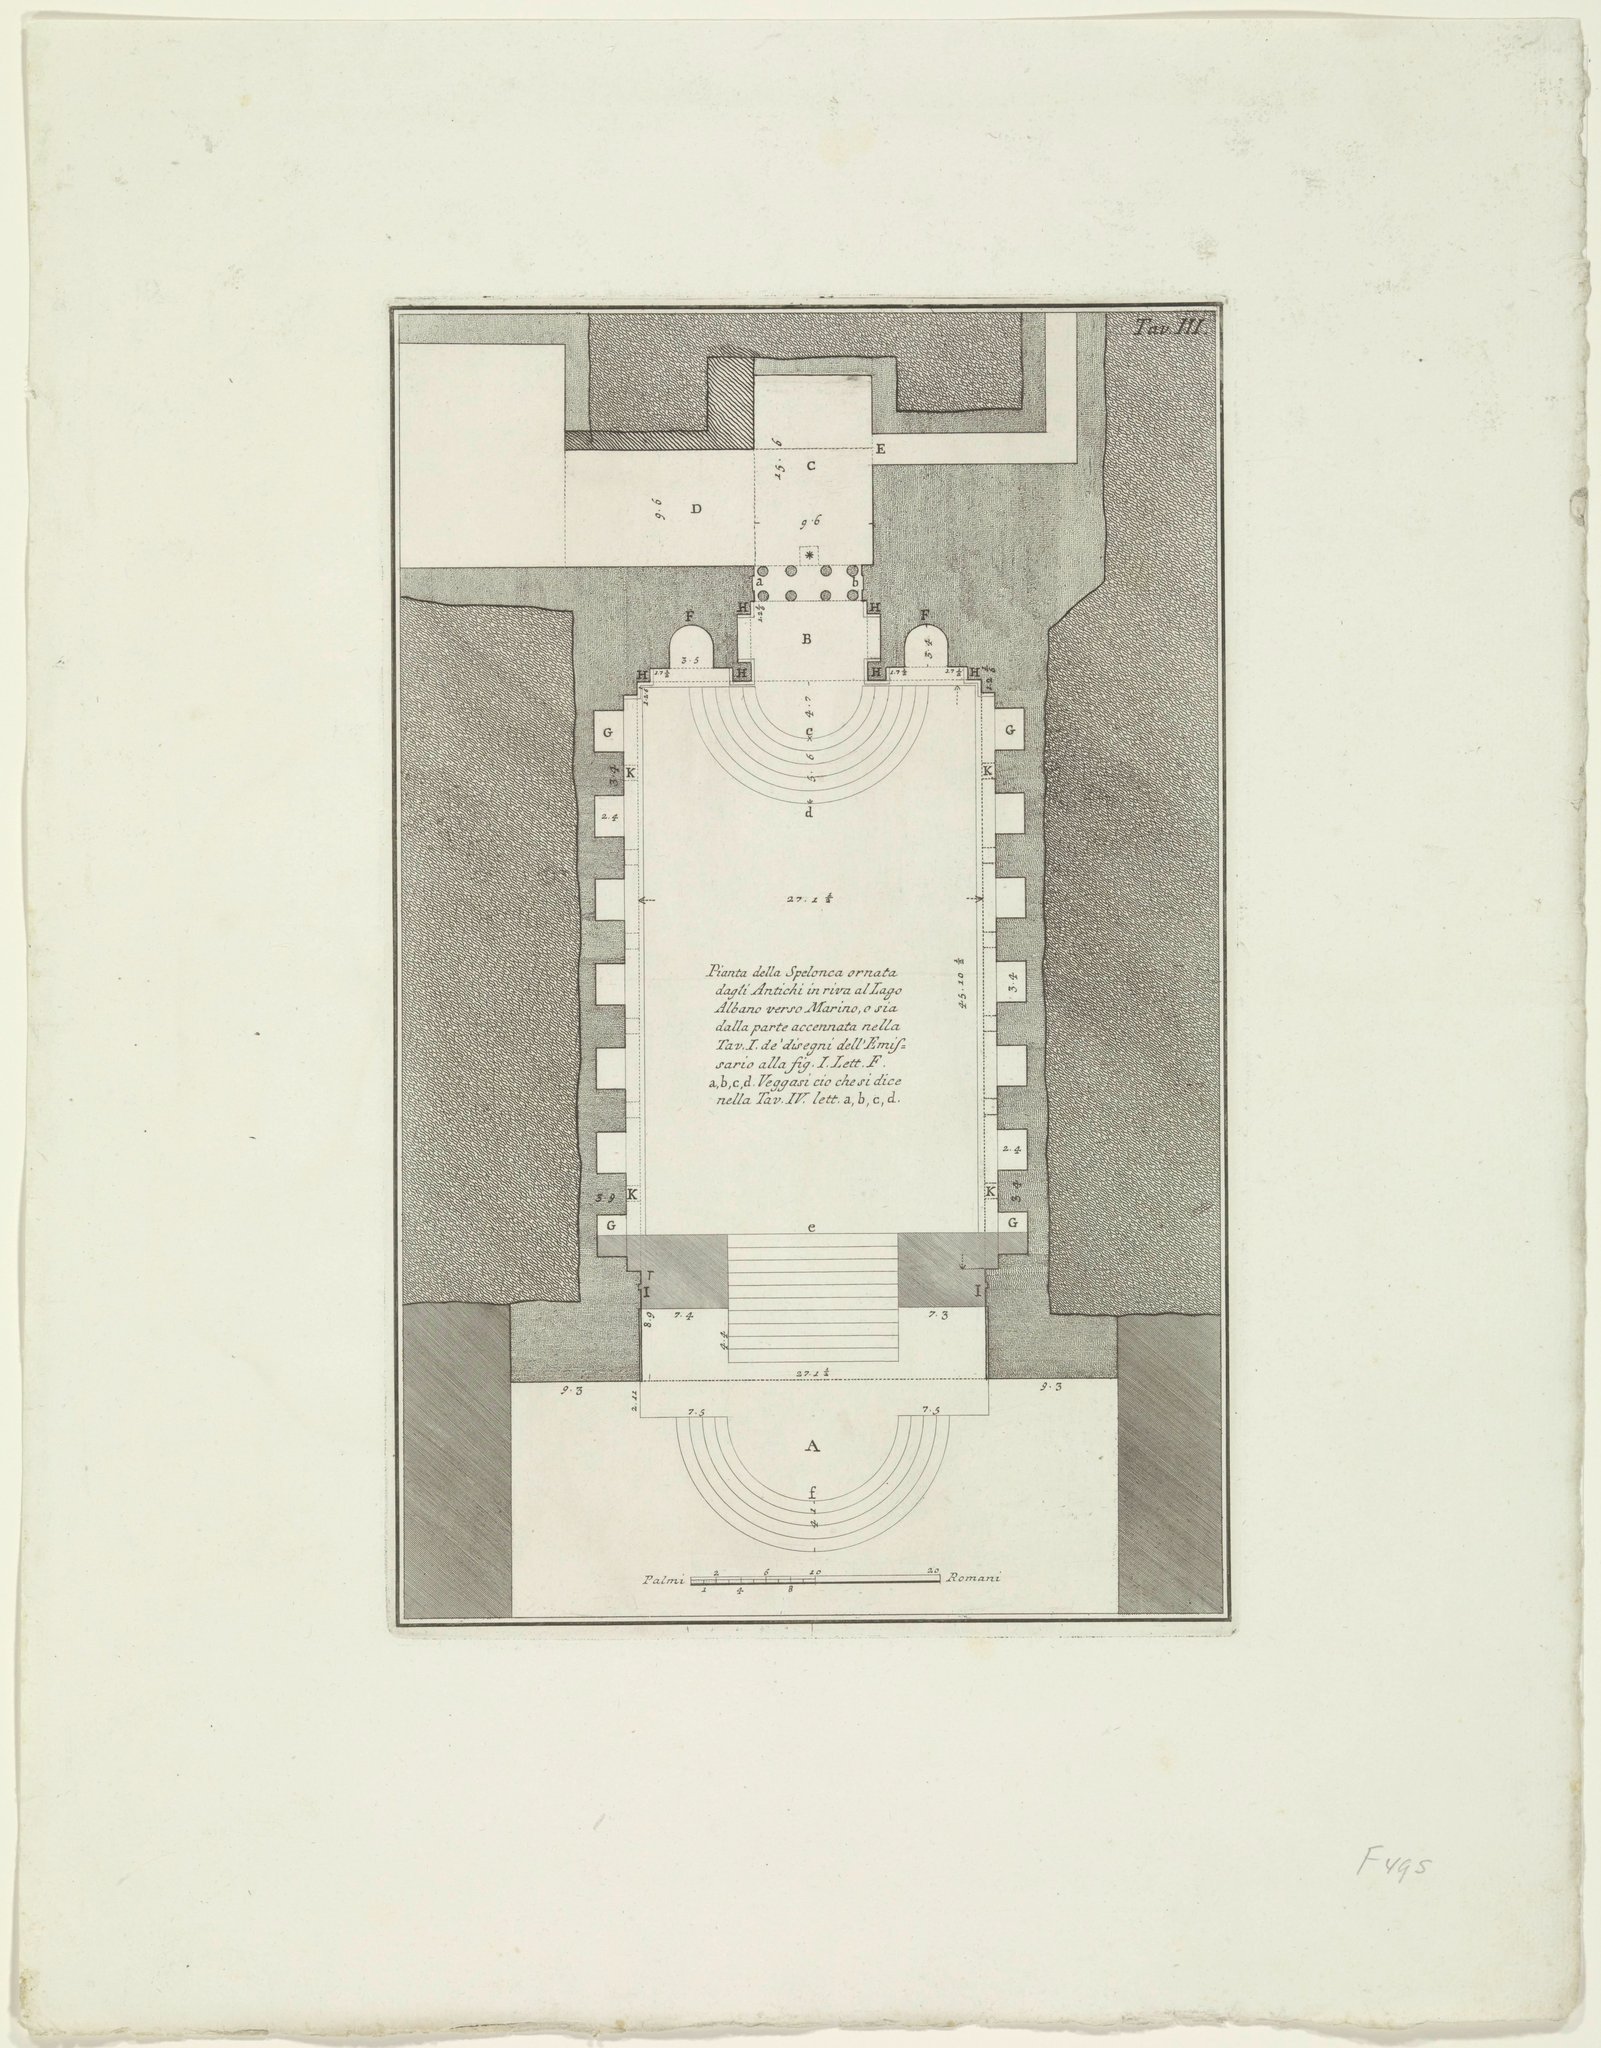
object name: print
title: Plattegrond van een grot bij het Meer van Albano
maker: giovanni battista piranesi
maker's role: designer, draughtsman, print maker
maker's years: 1720-1778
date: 1762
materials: paper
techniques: etching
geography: rome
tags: ruin of a building ~ architecture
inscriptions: collector's mark: Lugt 2228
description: Deze prent maakt deel uit van de serie 'Di due spelonche ornate dagli antichi alla Riva del Lago Albano'. De serie bestaat uit een vignet en twaalf prenten.